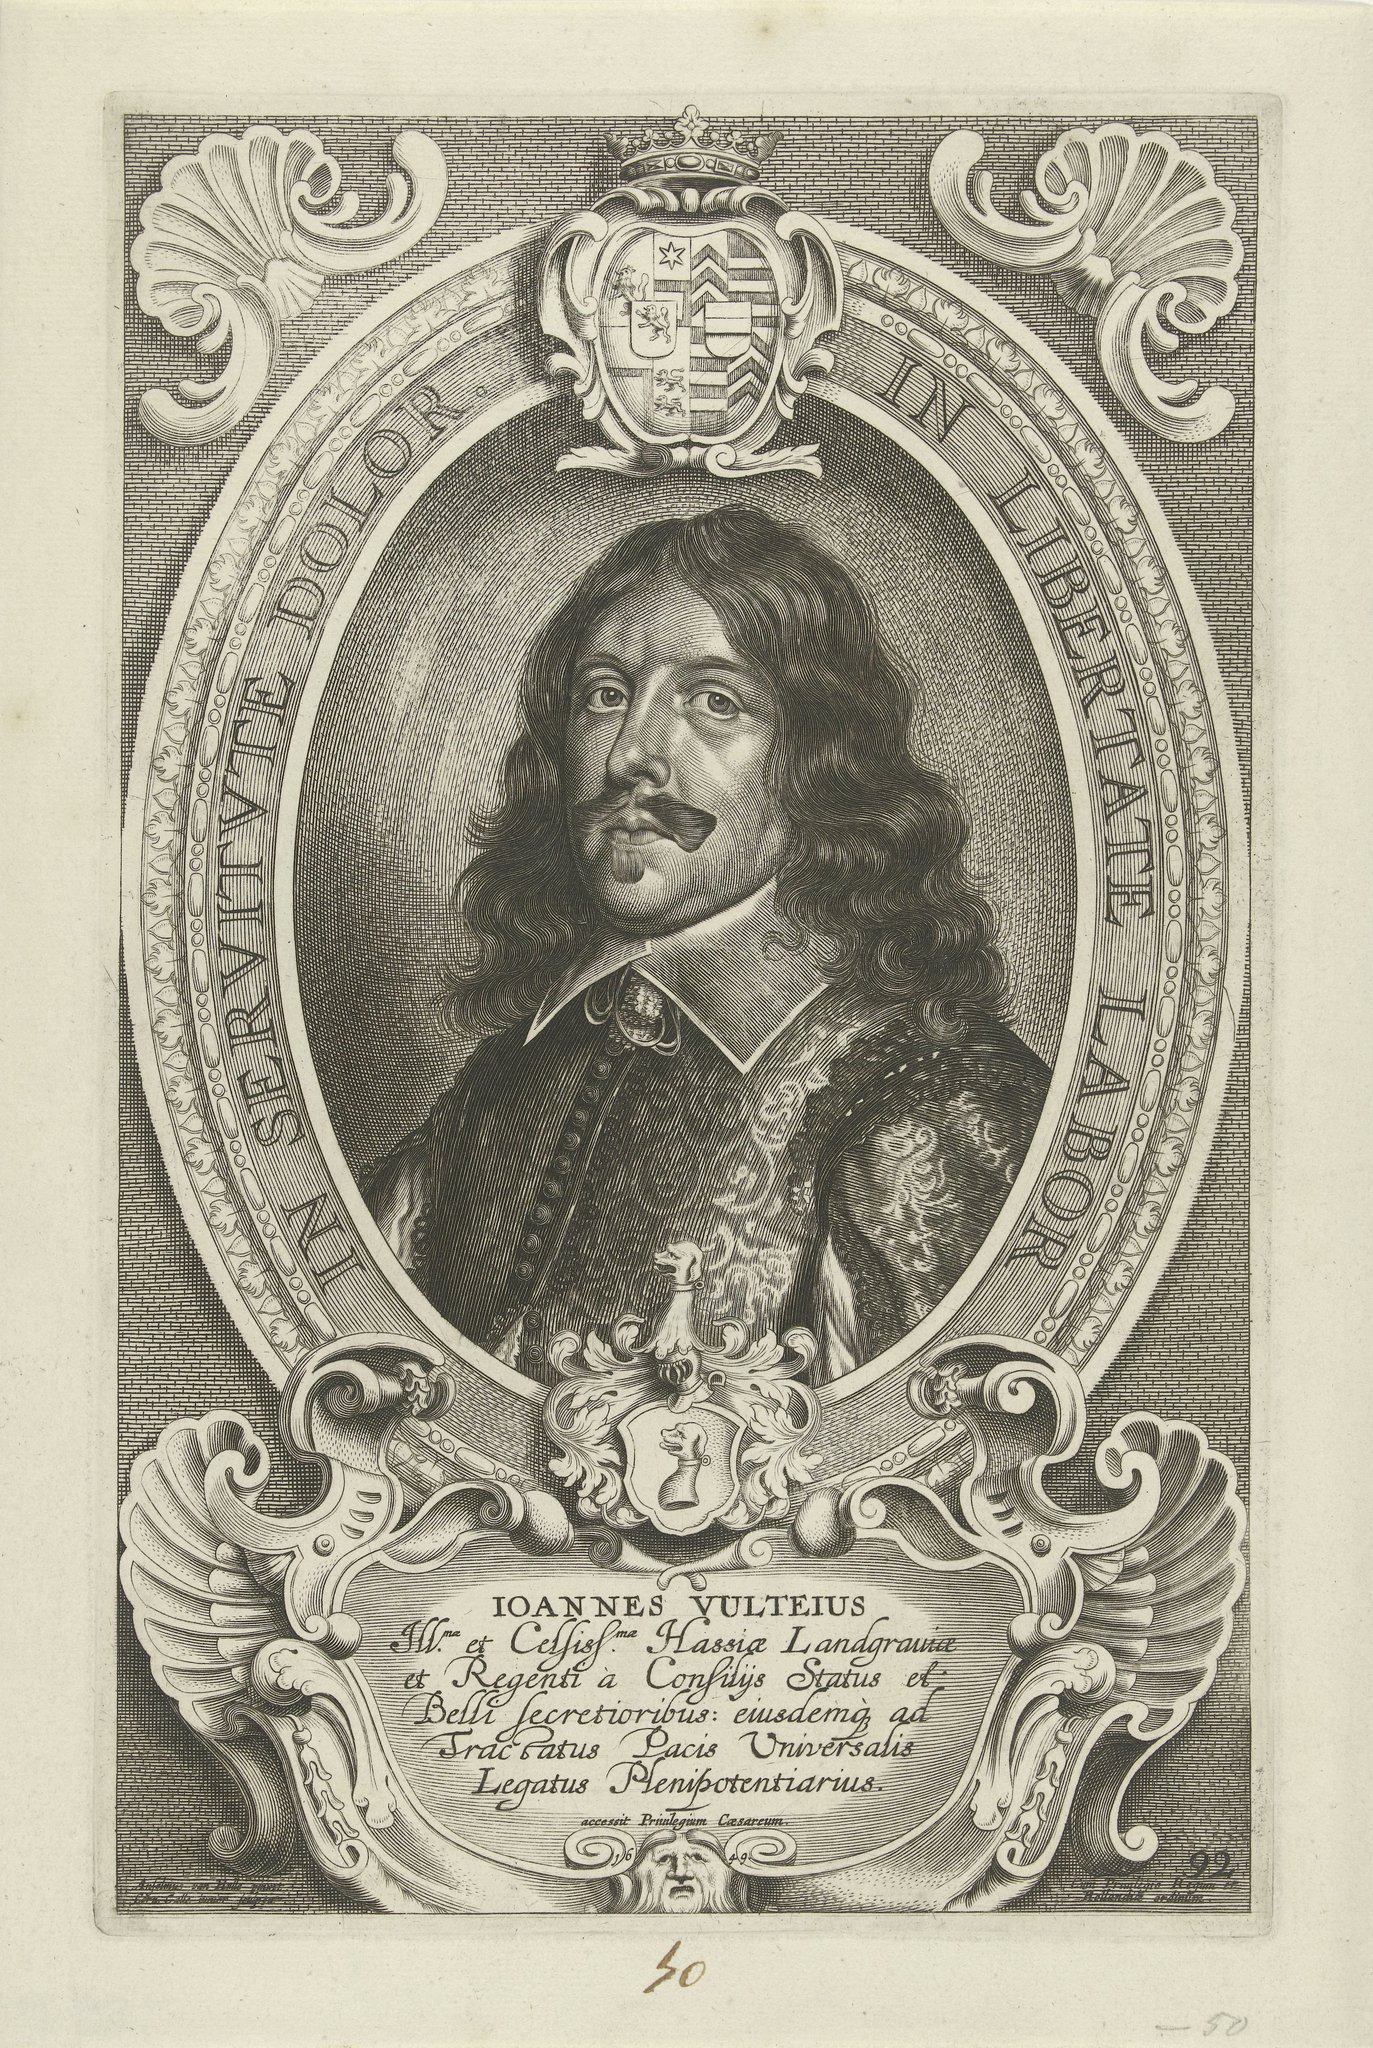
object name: print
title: Celeberrimi ad pacificandum Christiani nominis orbem legati Monasterium et Osnabrugas (...)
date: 1649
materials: paper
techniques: engraving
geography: antwerp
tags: marburg, jurist, afgezant, kanselier, johann vultejus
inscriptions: collector's mark: Lugt 2228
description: Portret van Johann Vultejus, afgezant voor de gravin Amalia Elisabeth van Hessen tijdens de onderhandelingen voor de Vrede van Münster. Portret in ovaal met motto. Onder het portret het familiewapen van Vultejus, boven het wapen van Hessen.